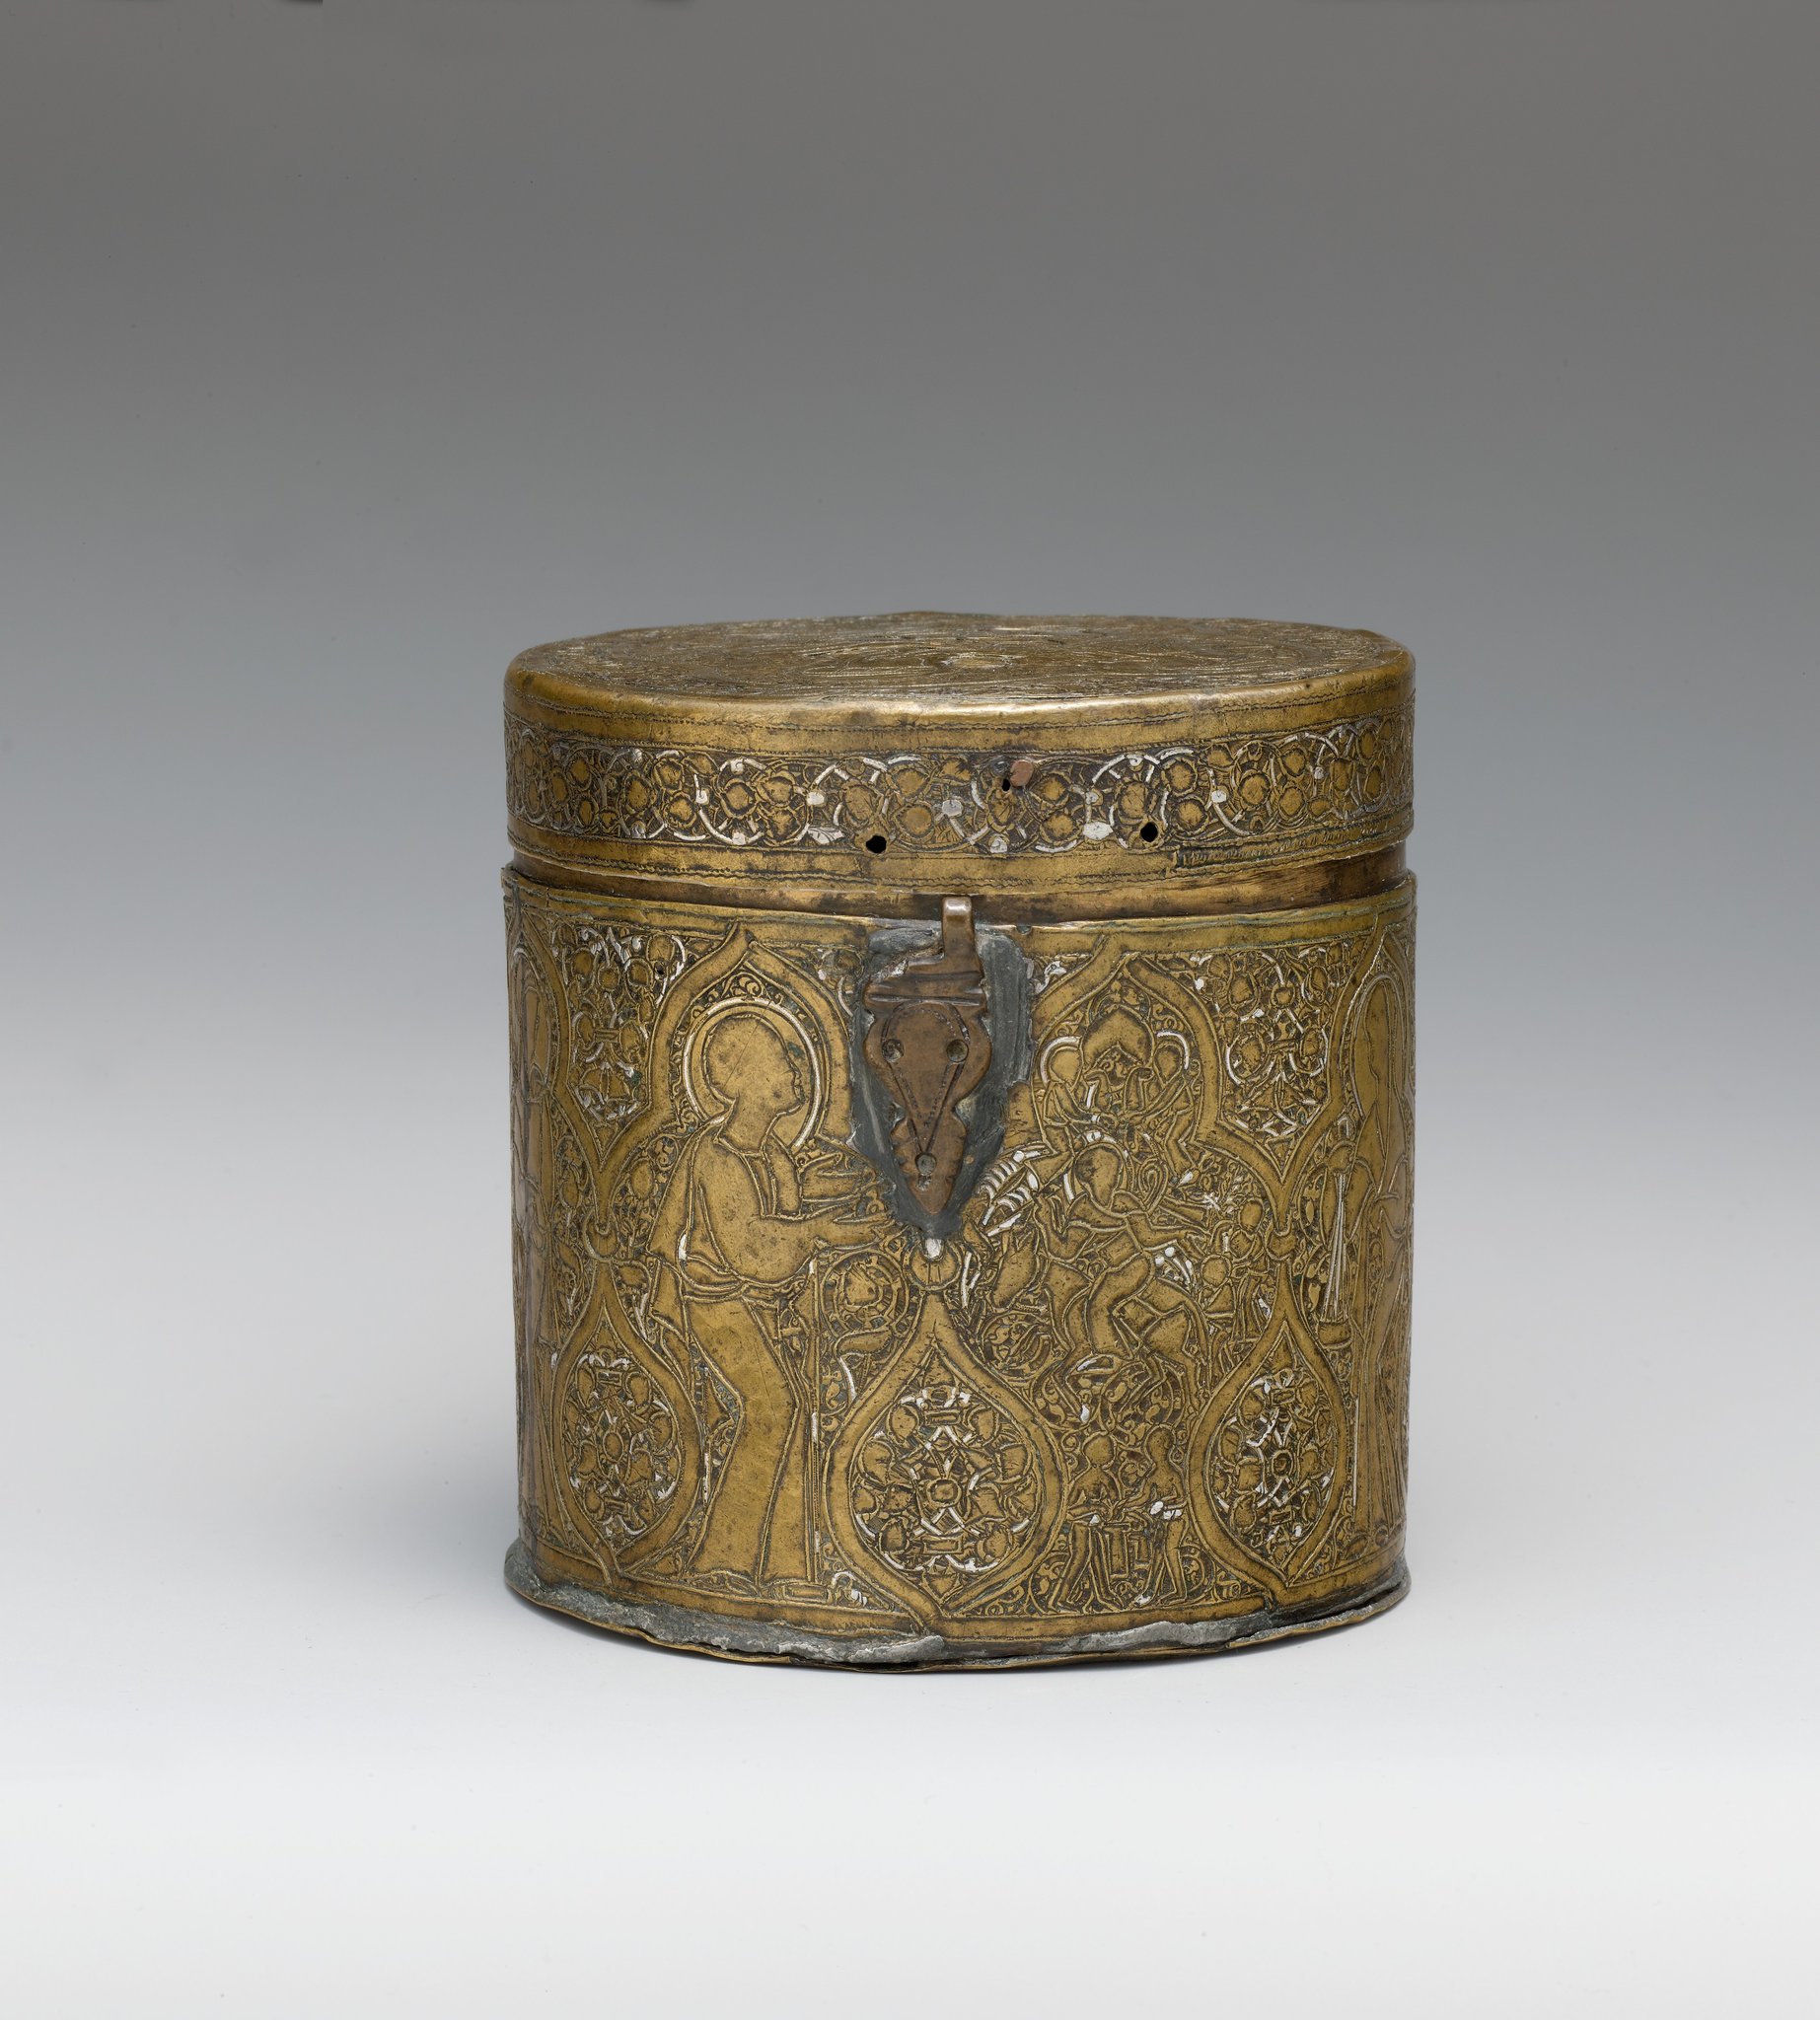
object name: box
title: Pyxis Depicting Standing Saints or Ecclesiastics and the Entry into Jerusalem with Christ Riding a Donkey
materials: brass, silver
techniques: engraving, hammering, inlay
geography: syria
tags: men,donkeys,christ